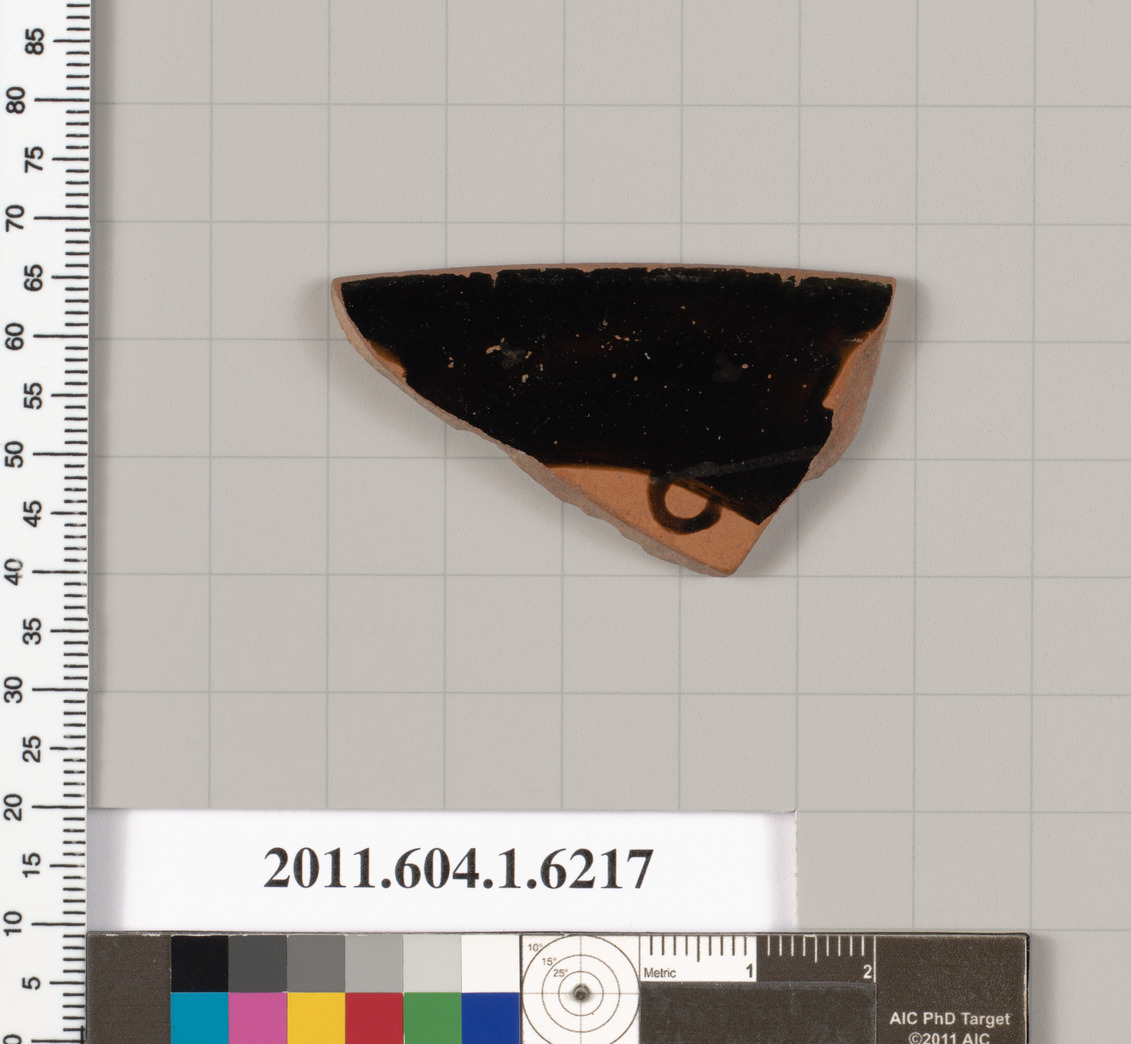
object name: kylix fragment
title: Terracotta rim fragment of a kylix (drinking cup)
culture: greek, attic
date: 510-500 BCE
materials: terracotta